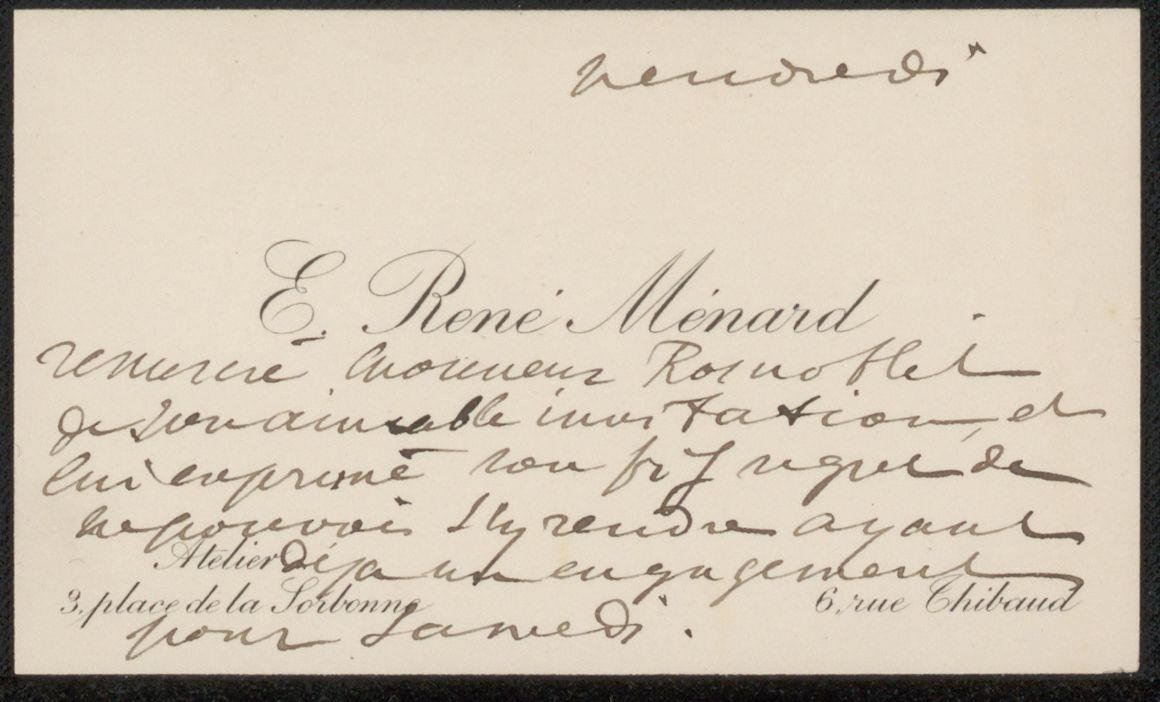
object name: visiting card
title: Visitekaartje aan Philip Zilcken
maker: rené ménard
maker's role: painter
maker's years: 1862-1930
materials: cardboard, ink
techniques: pen, printing, writing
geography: paris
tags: the hague, draughtsman, philip zilcken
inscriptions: collector's mark: ‘RPK’